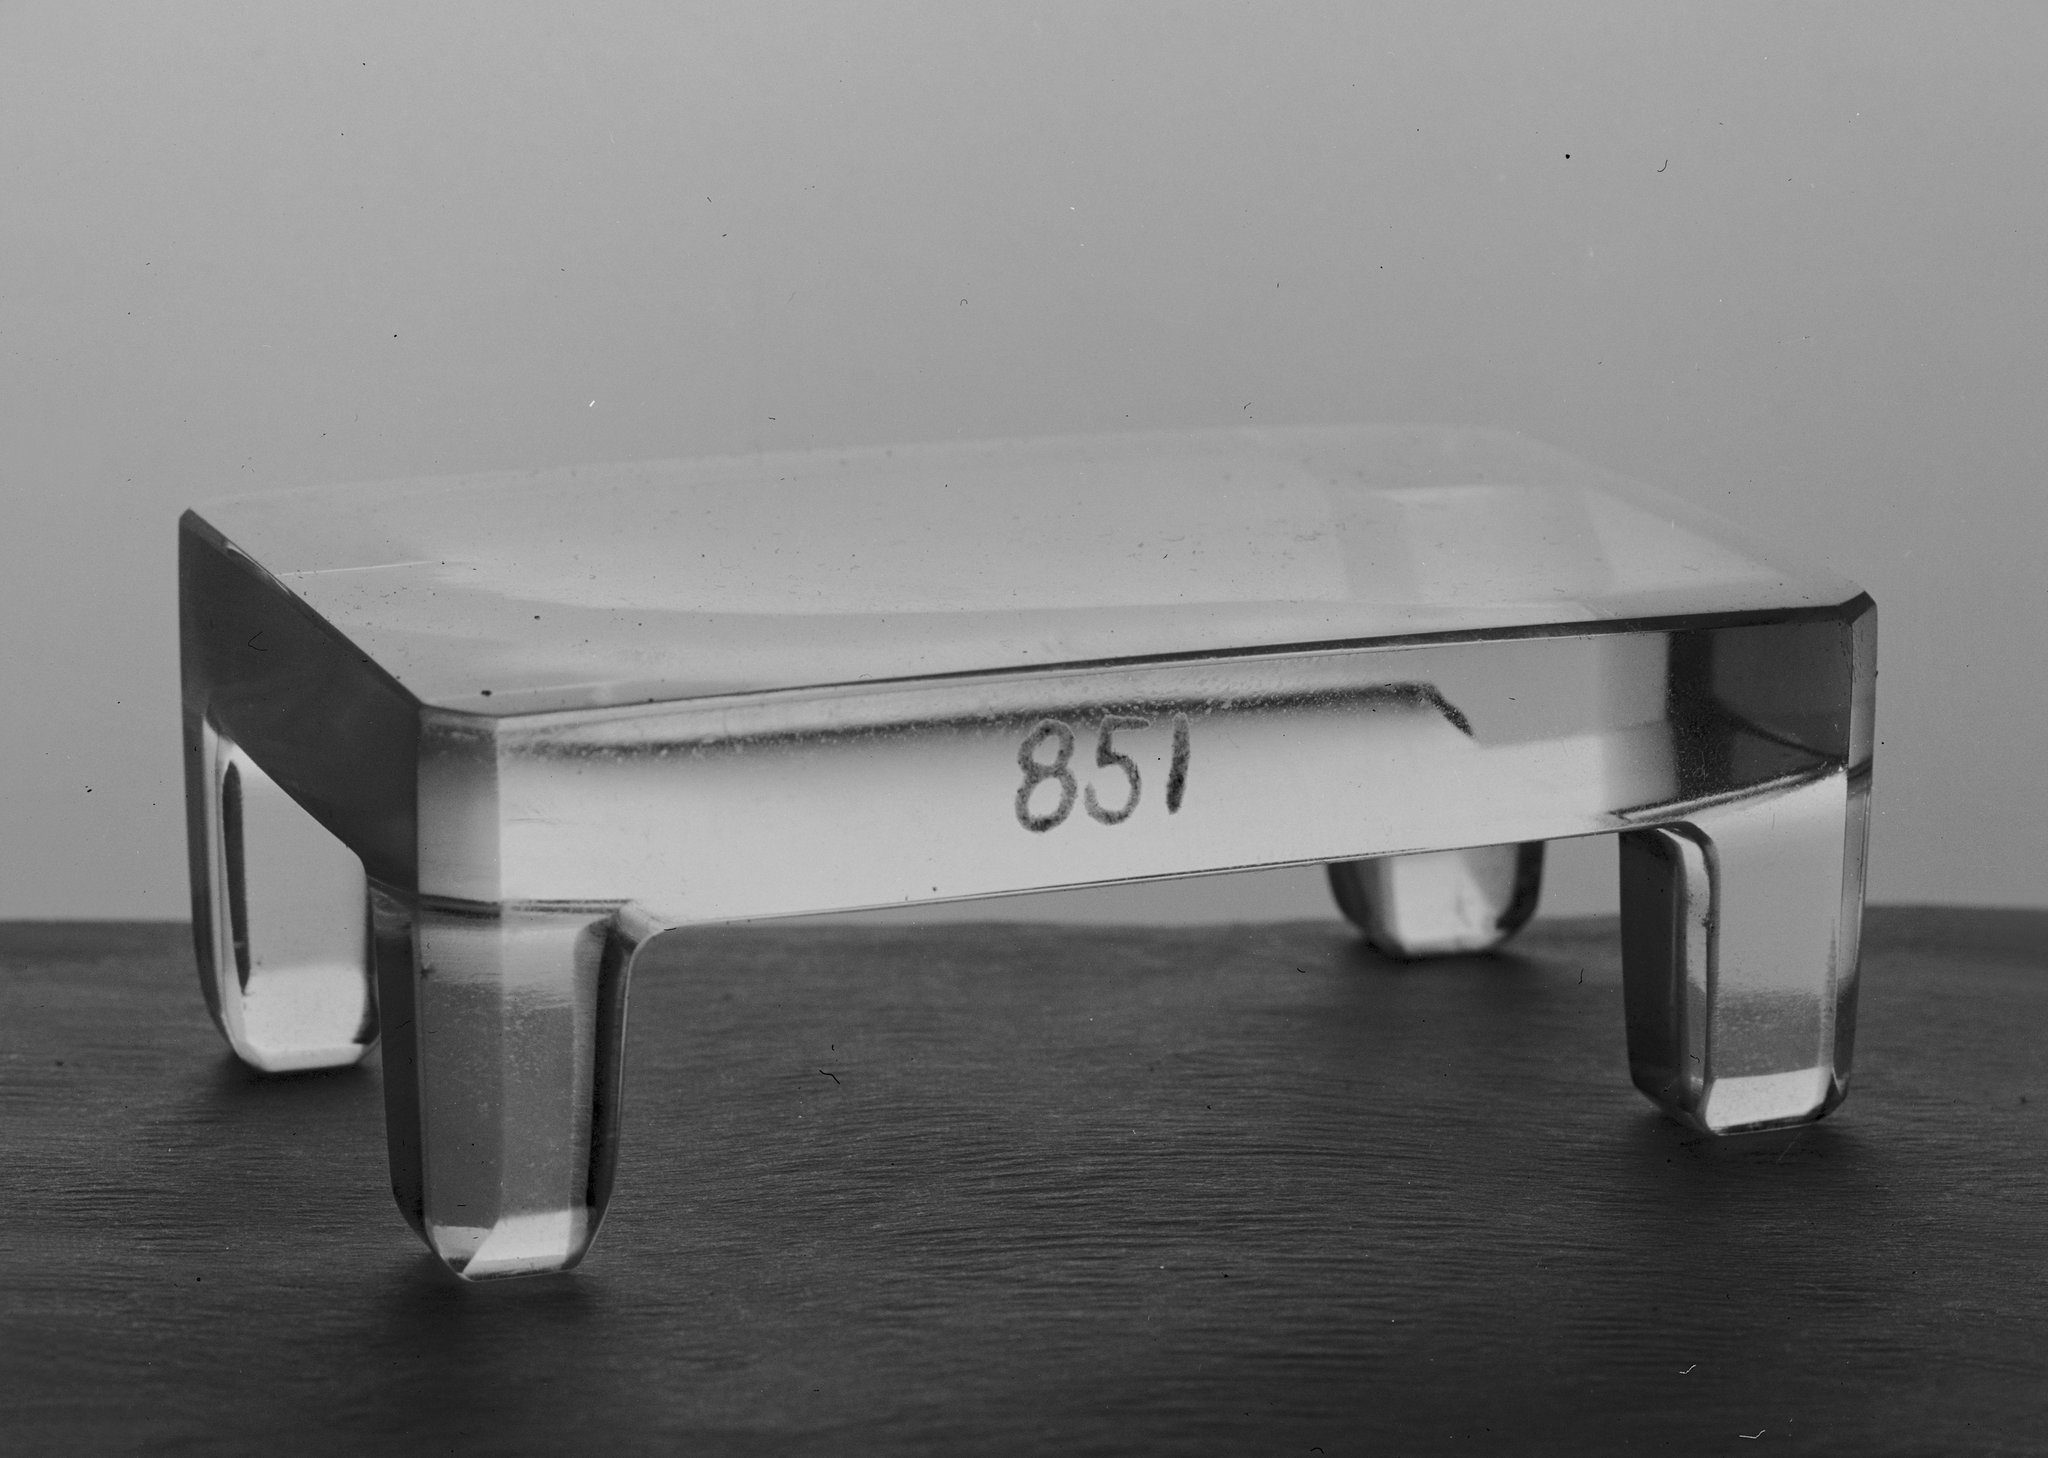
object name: stand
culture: chinese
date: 1701-1800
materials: quartz